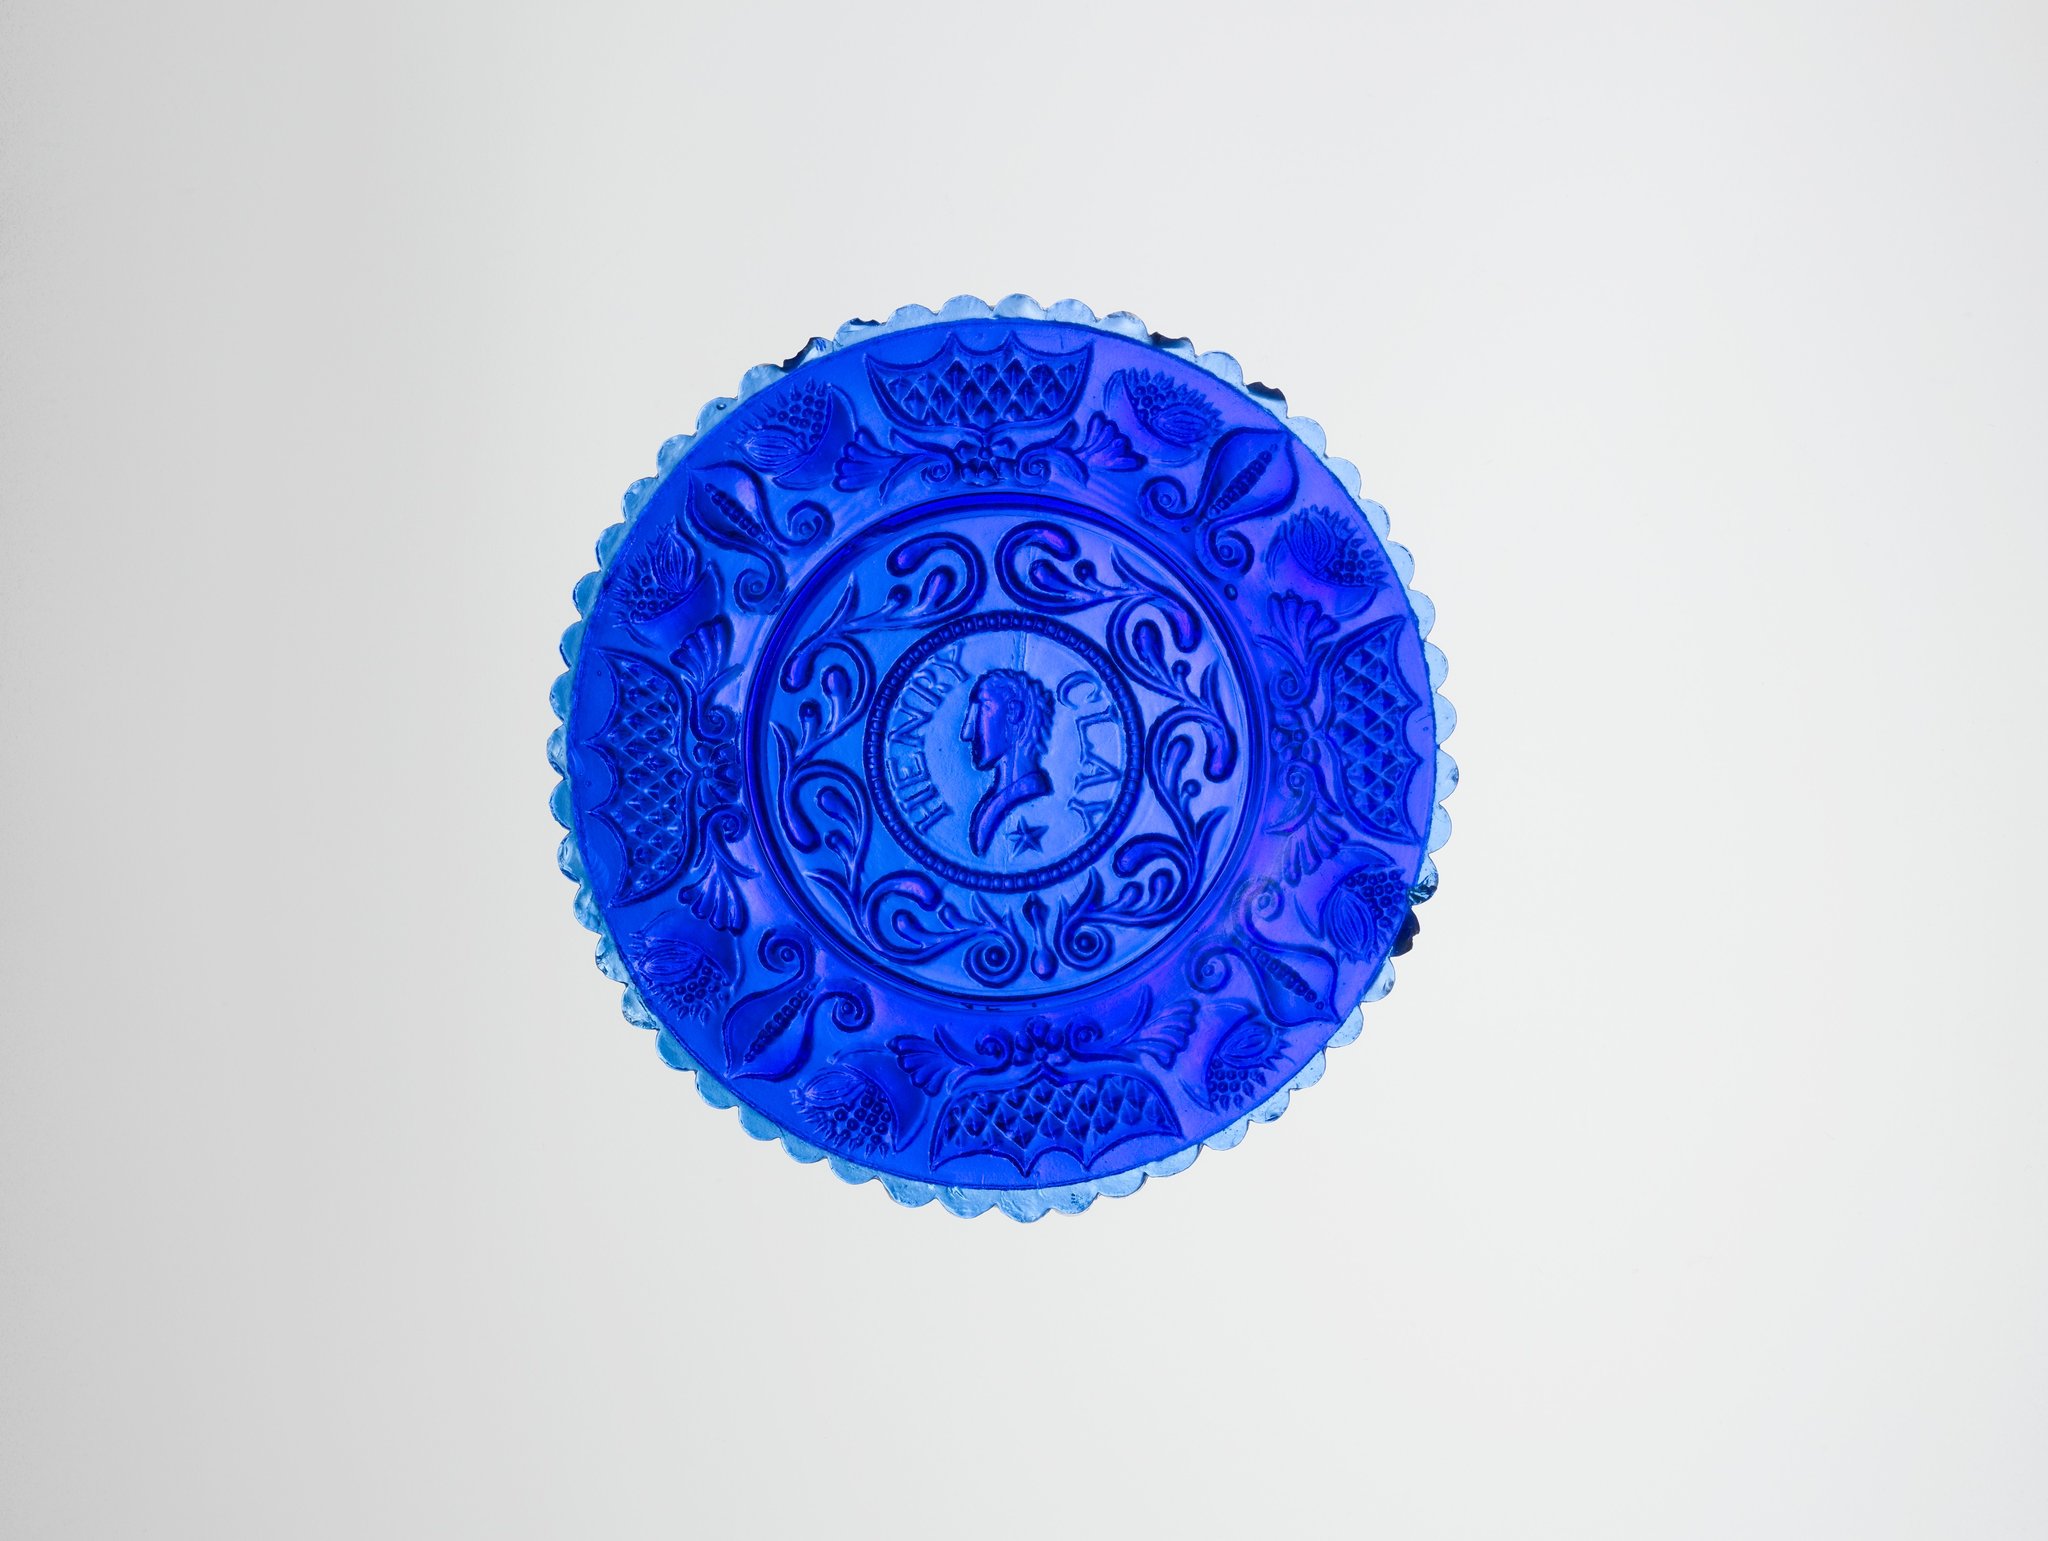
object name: cup plate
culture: american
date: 1840-1852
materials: glass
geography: united states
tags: men